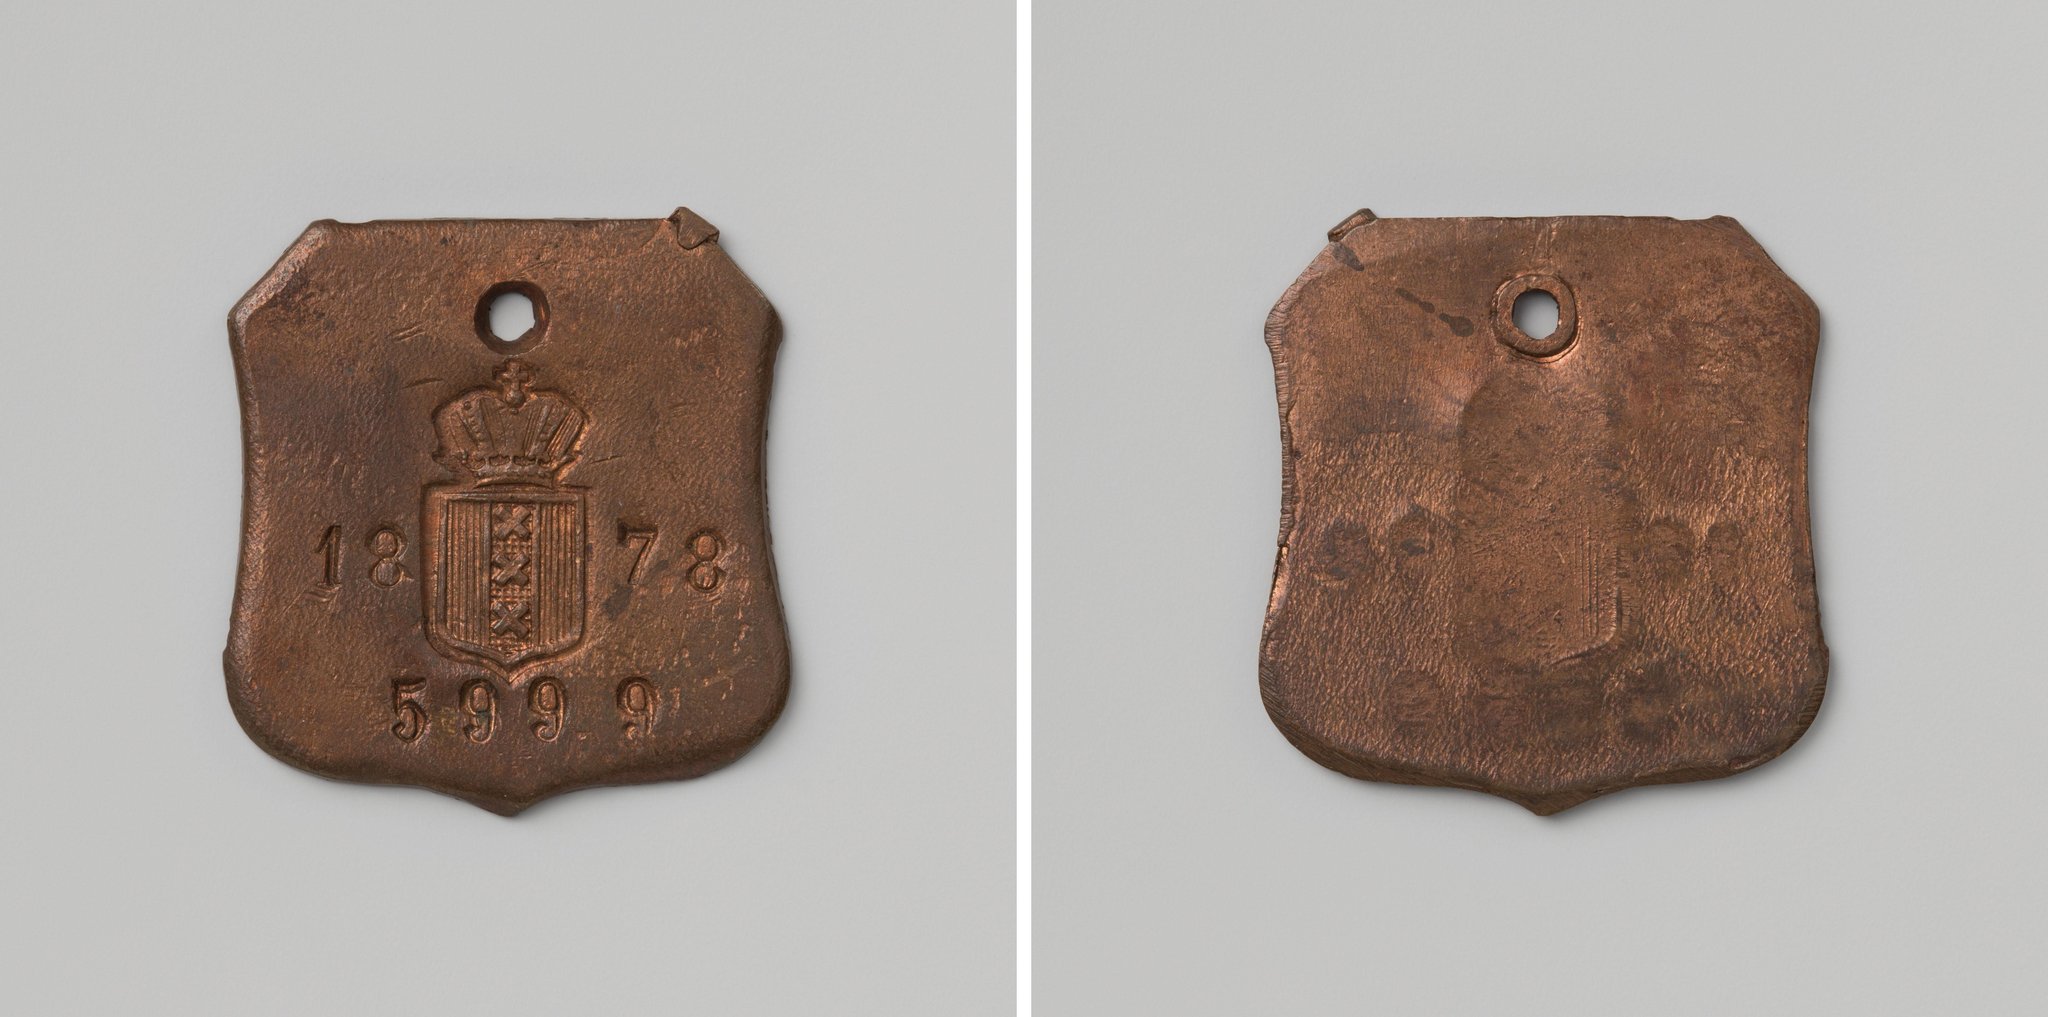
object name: tax token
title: Stad Amsterdam, loodje met no. 5999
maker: Anonymous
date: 1878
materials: copper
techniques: striking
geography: amsterdam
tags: amsterdam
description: eenzijdig, ruitvormig loodje met holle zijden, aan bovenzijde afgeschuinde hoeken en gat, en aan onderzijde afgeronde hoeken en eindigend in punt. Voorzijde: gekroond wapenschild tussen jaartal boven cijfer 5999. Keerzijde: blanco